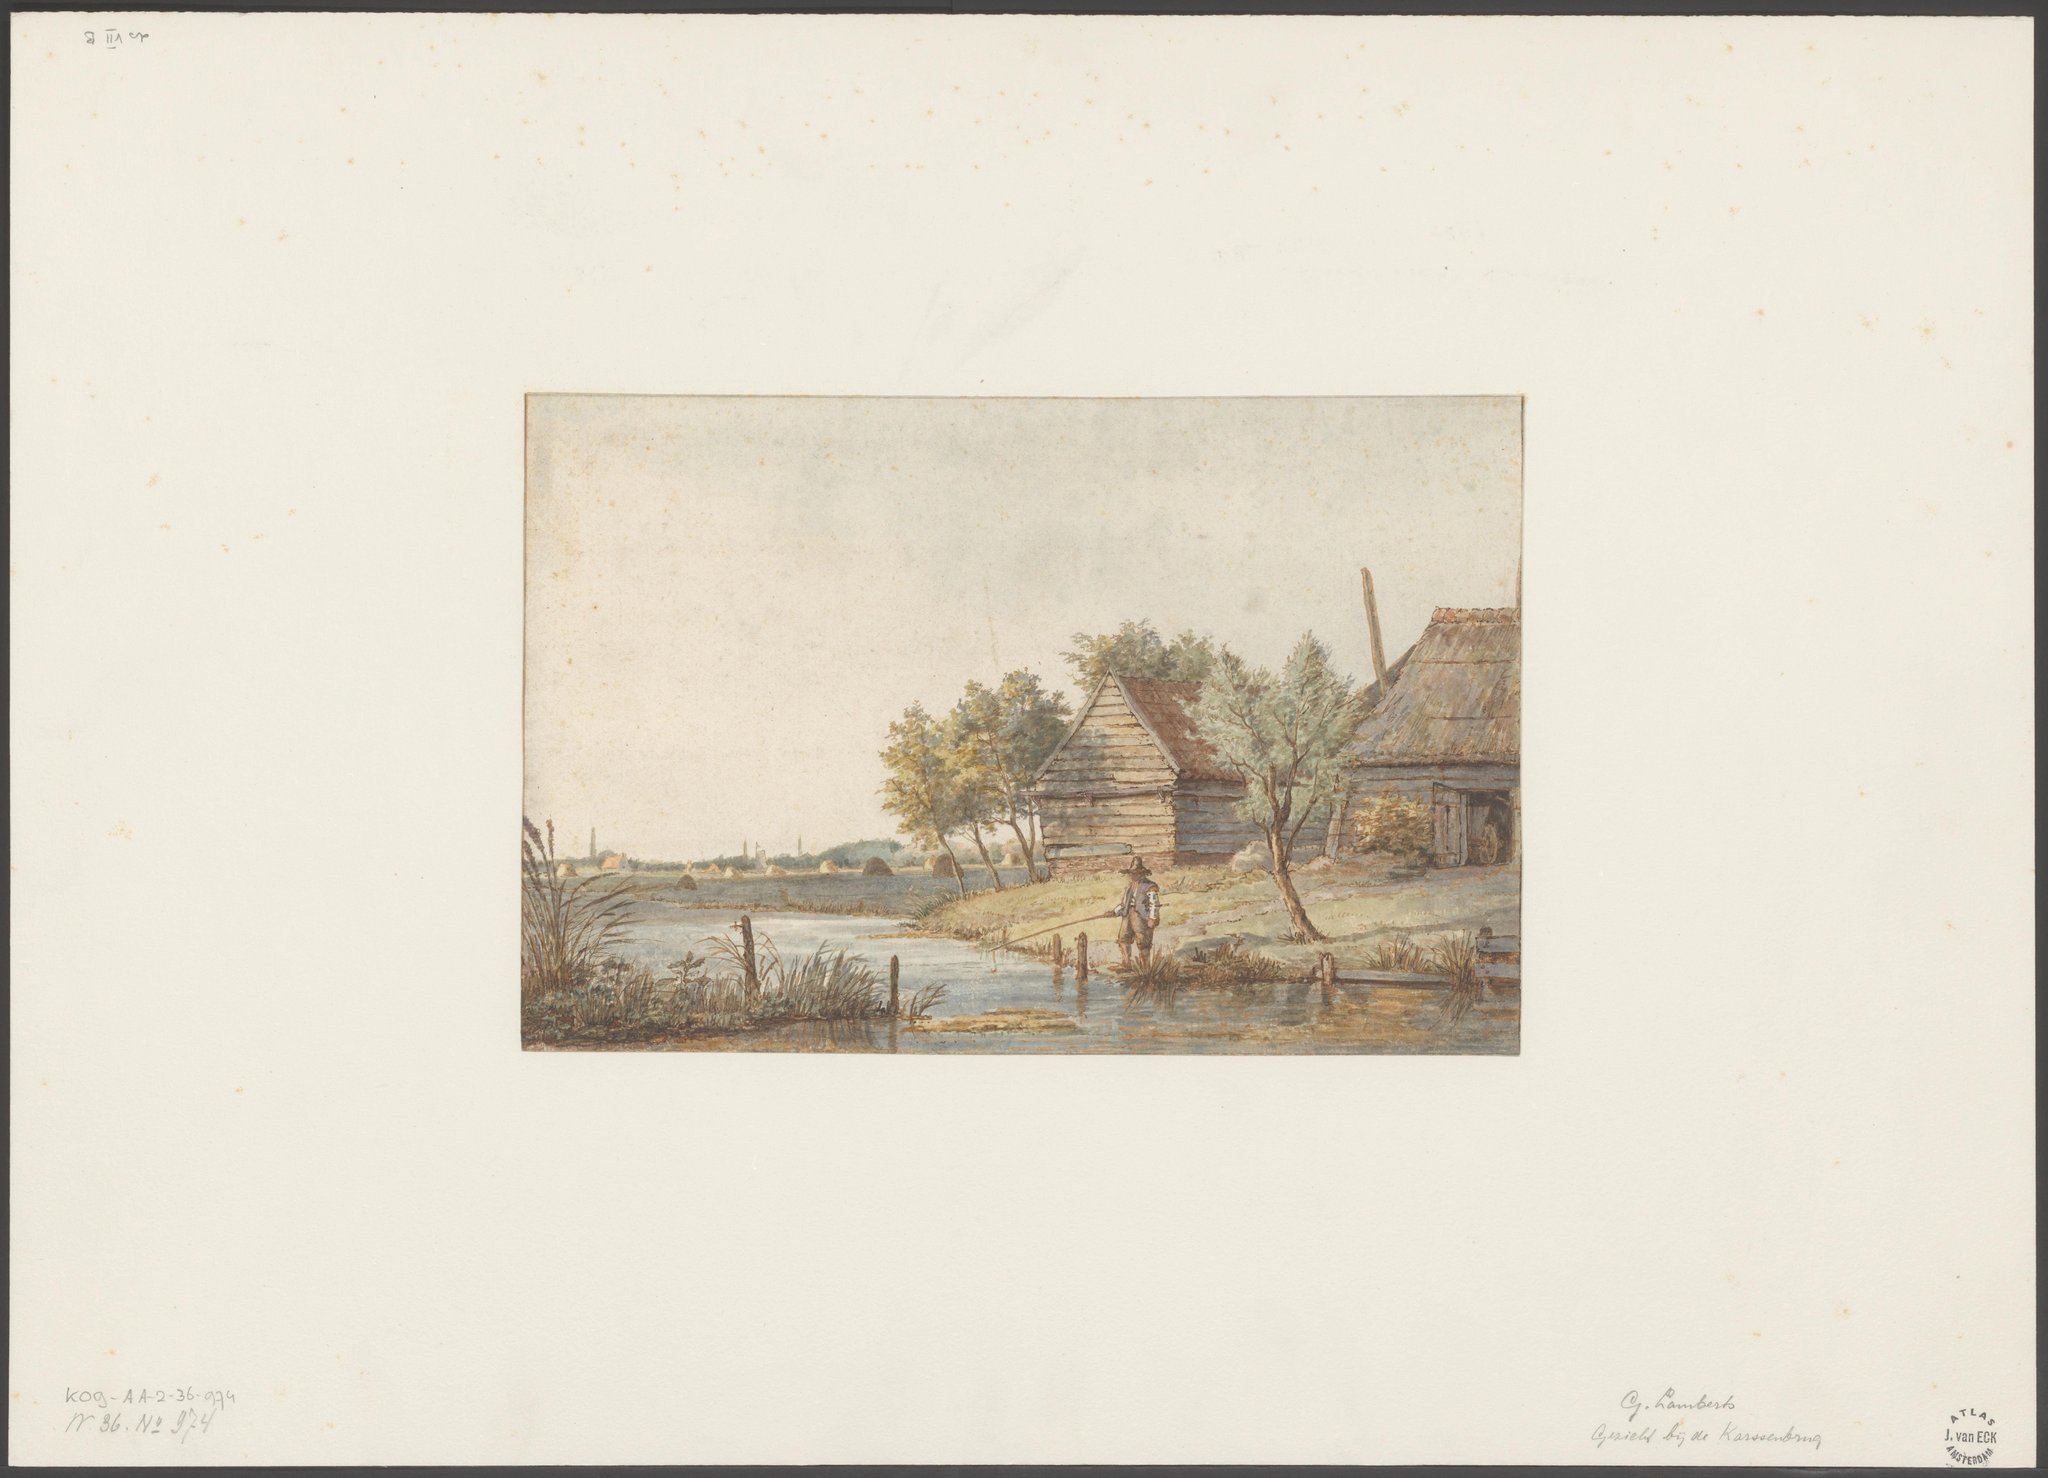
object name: drawing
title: Gezicht nabij Amstelveen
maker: gerrit lamberts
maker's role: bookseller, draughtsman, print maker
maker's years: 1776-1850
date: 1815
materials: ink, paper, watercolor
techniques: brush, pen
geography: amsterdam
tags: river, village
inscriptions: collector's mark: Lugt 800a, signature and date: ‘G. Lamberts. 1815.’, inscription: ‘Gezicht aan de Karssen Brug / nabij Amstelveen, ziende op amsterdam’, inscription: ‘Gerrit Lamberts / Amsterdam 1776/1850’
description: Tekening binnen de Atlas Van Eck ingedeeld op wijknummer 36.